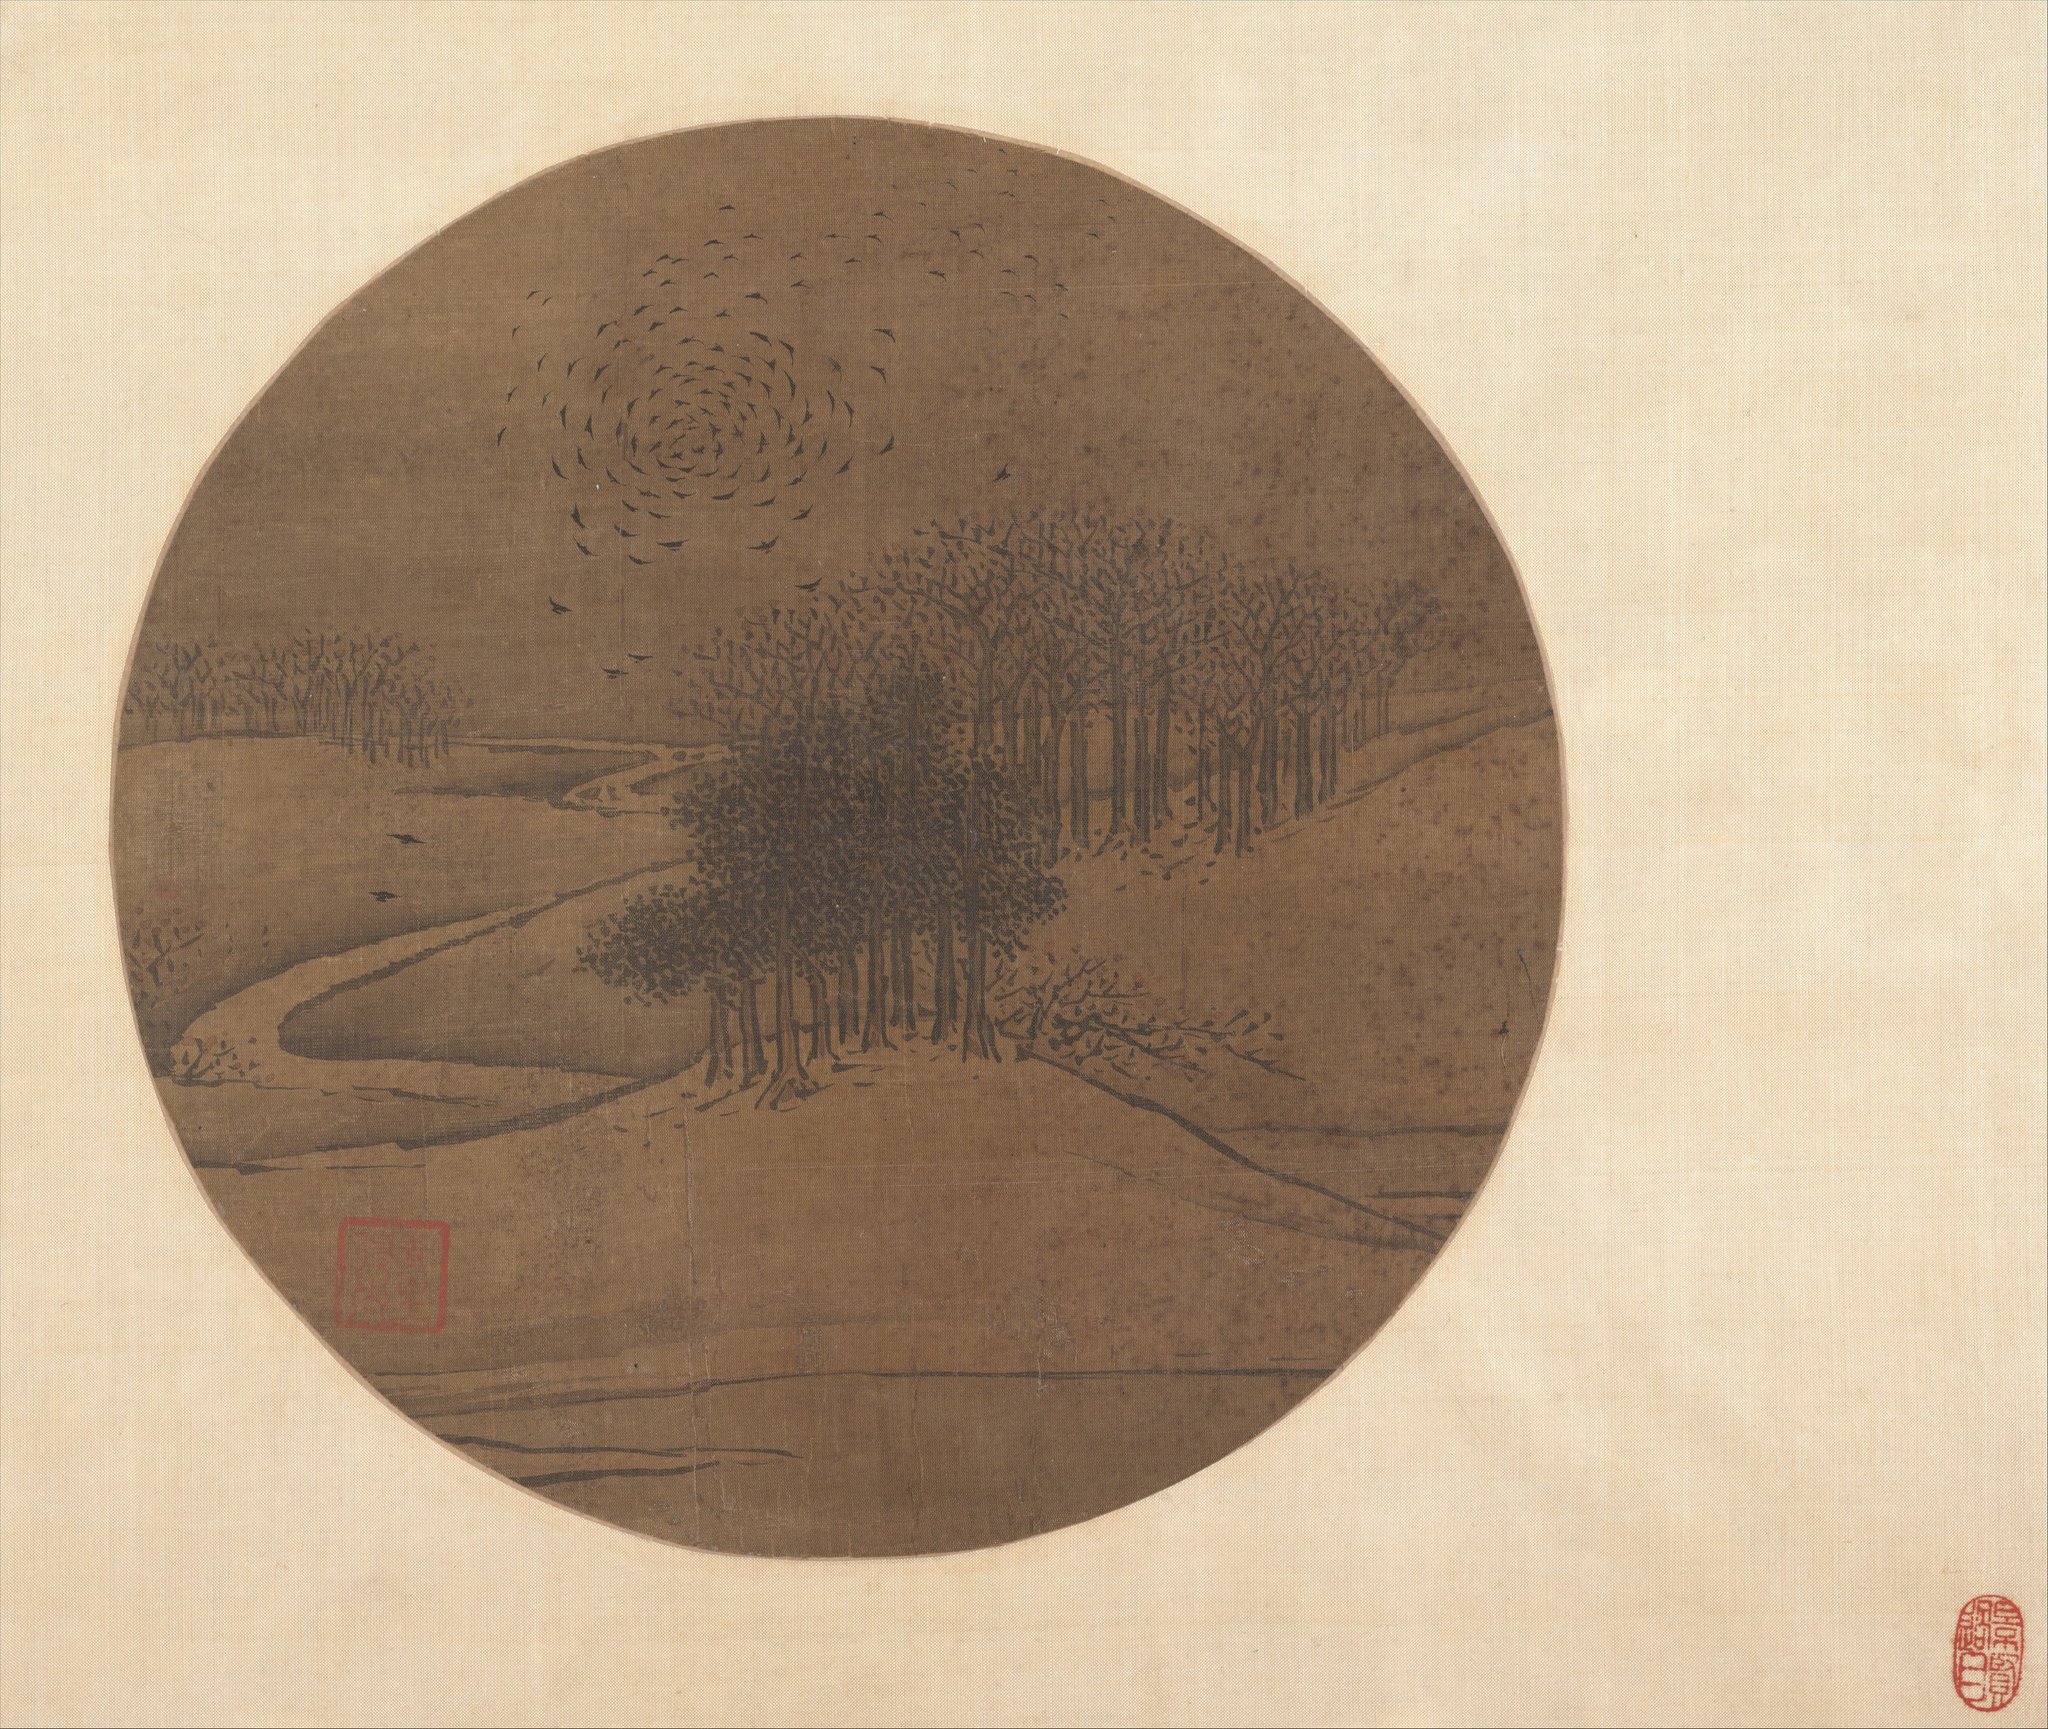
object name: folding fan mounted a an album leaf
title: Crows and Bare Trees in Winter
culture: chinese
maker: unidentified artist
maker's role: artist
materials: ink, silk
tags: birds,trees